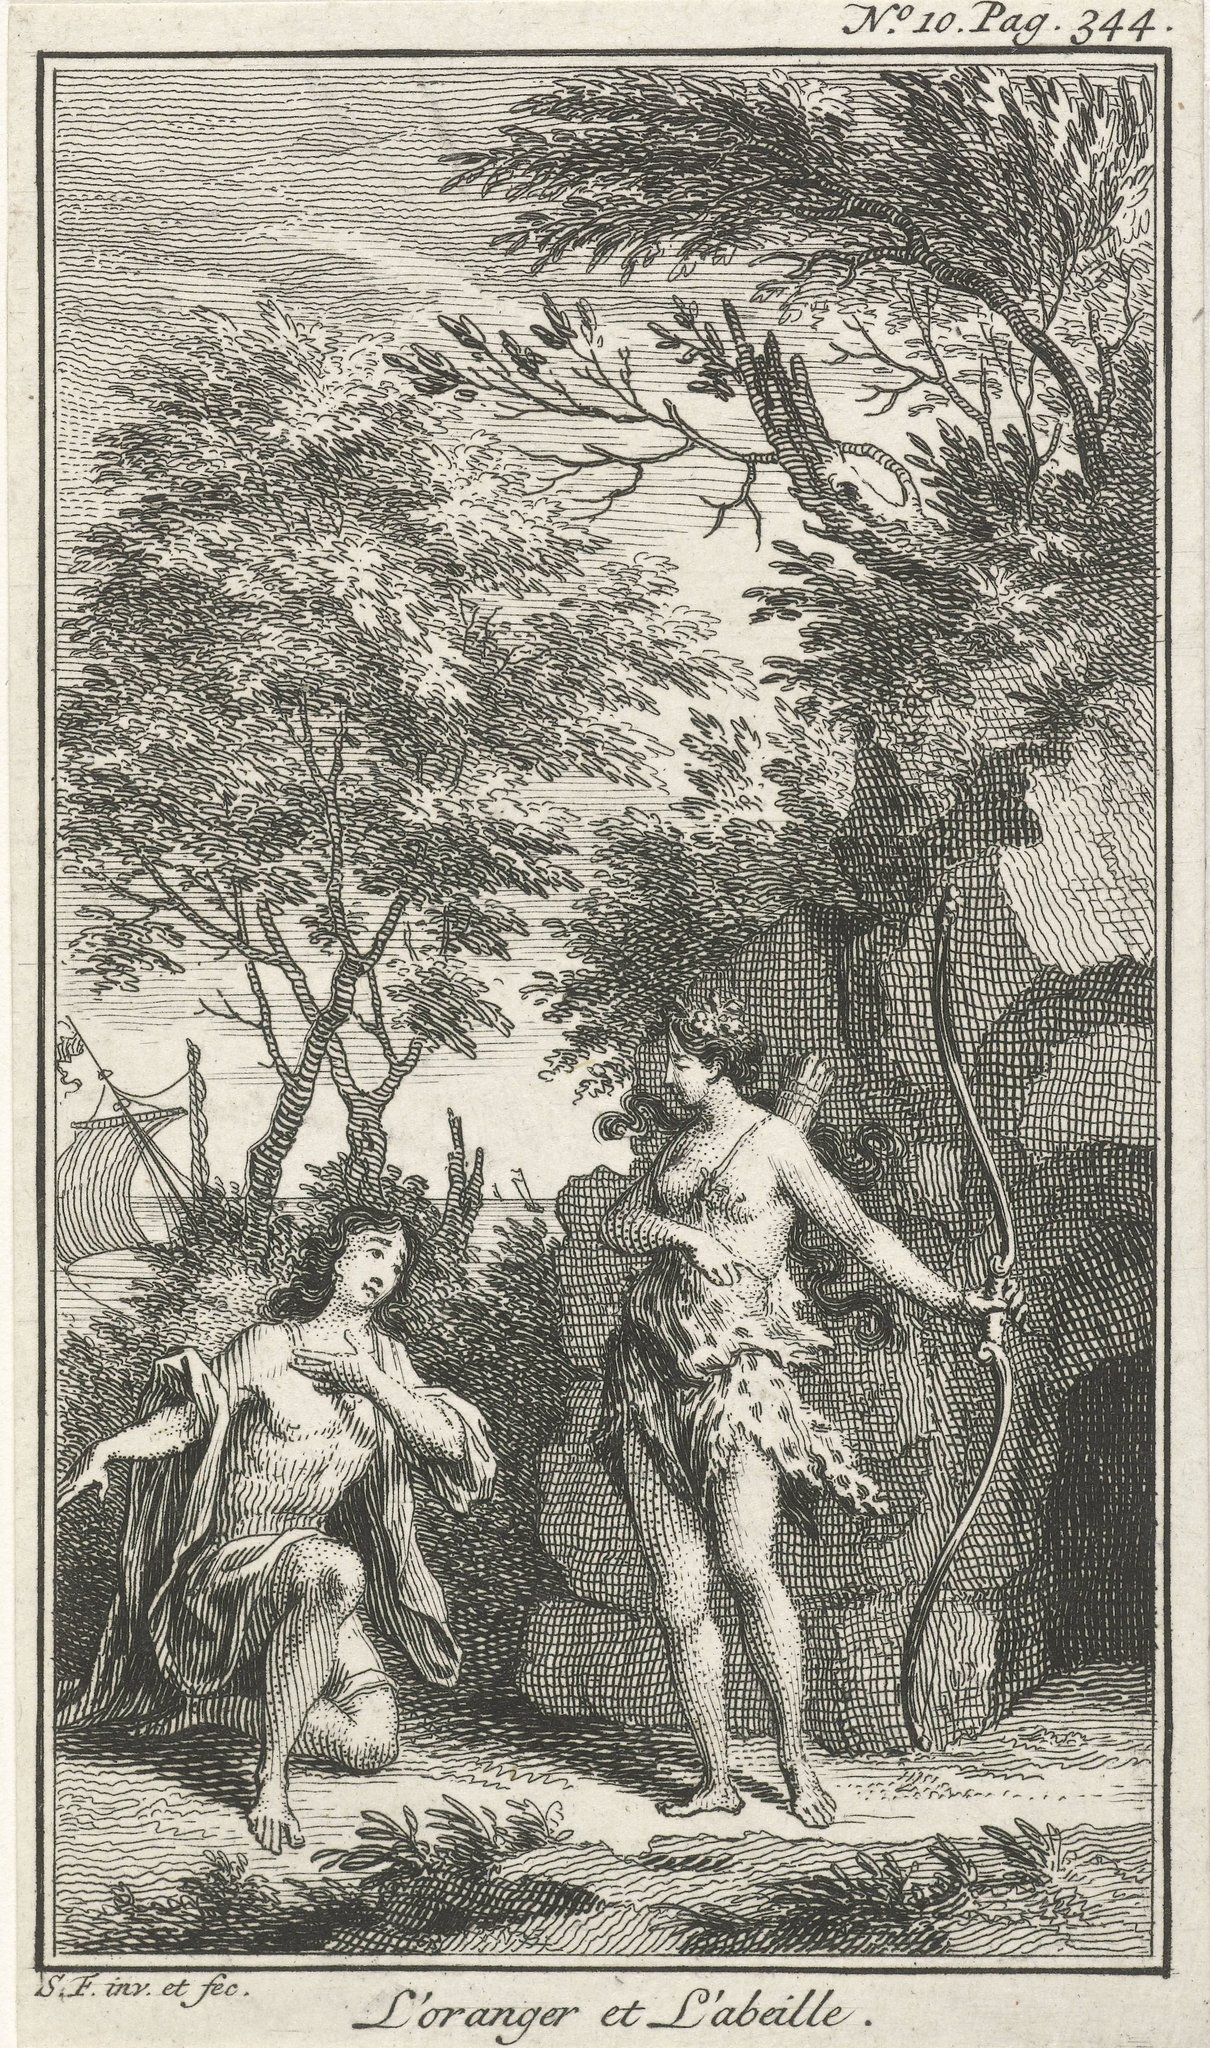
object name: print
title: Man knielt bij de ingang van een grot voor een vrouw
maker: simon fokke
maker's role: draughtsman, print maker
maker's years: 1712-1784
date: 1722-1784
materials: paper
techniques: etching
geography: amsterdam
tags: archer's weapons: bow and arrow, cave, grotto, kneeling figure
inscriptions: collector's mark: Lugt 240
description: Illustratie uit het sprookje L'oranger et L'abeille van Mme d'Aulnoy. Bij de ingang van een grot knielt een man voor een in dierenvacht gehulde vrouw. De vrouw draagt een koker gevuld met pijlen op haar rug en een boog in haar hand. Prent rechtsboven gemerkt: No. 10. Pag. 344.